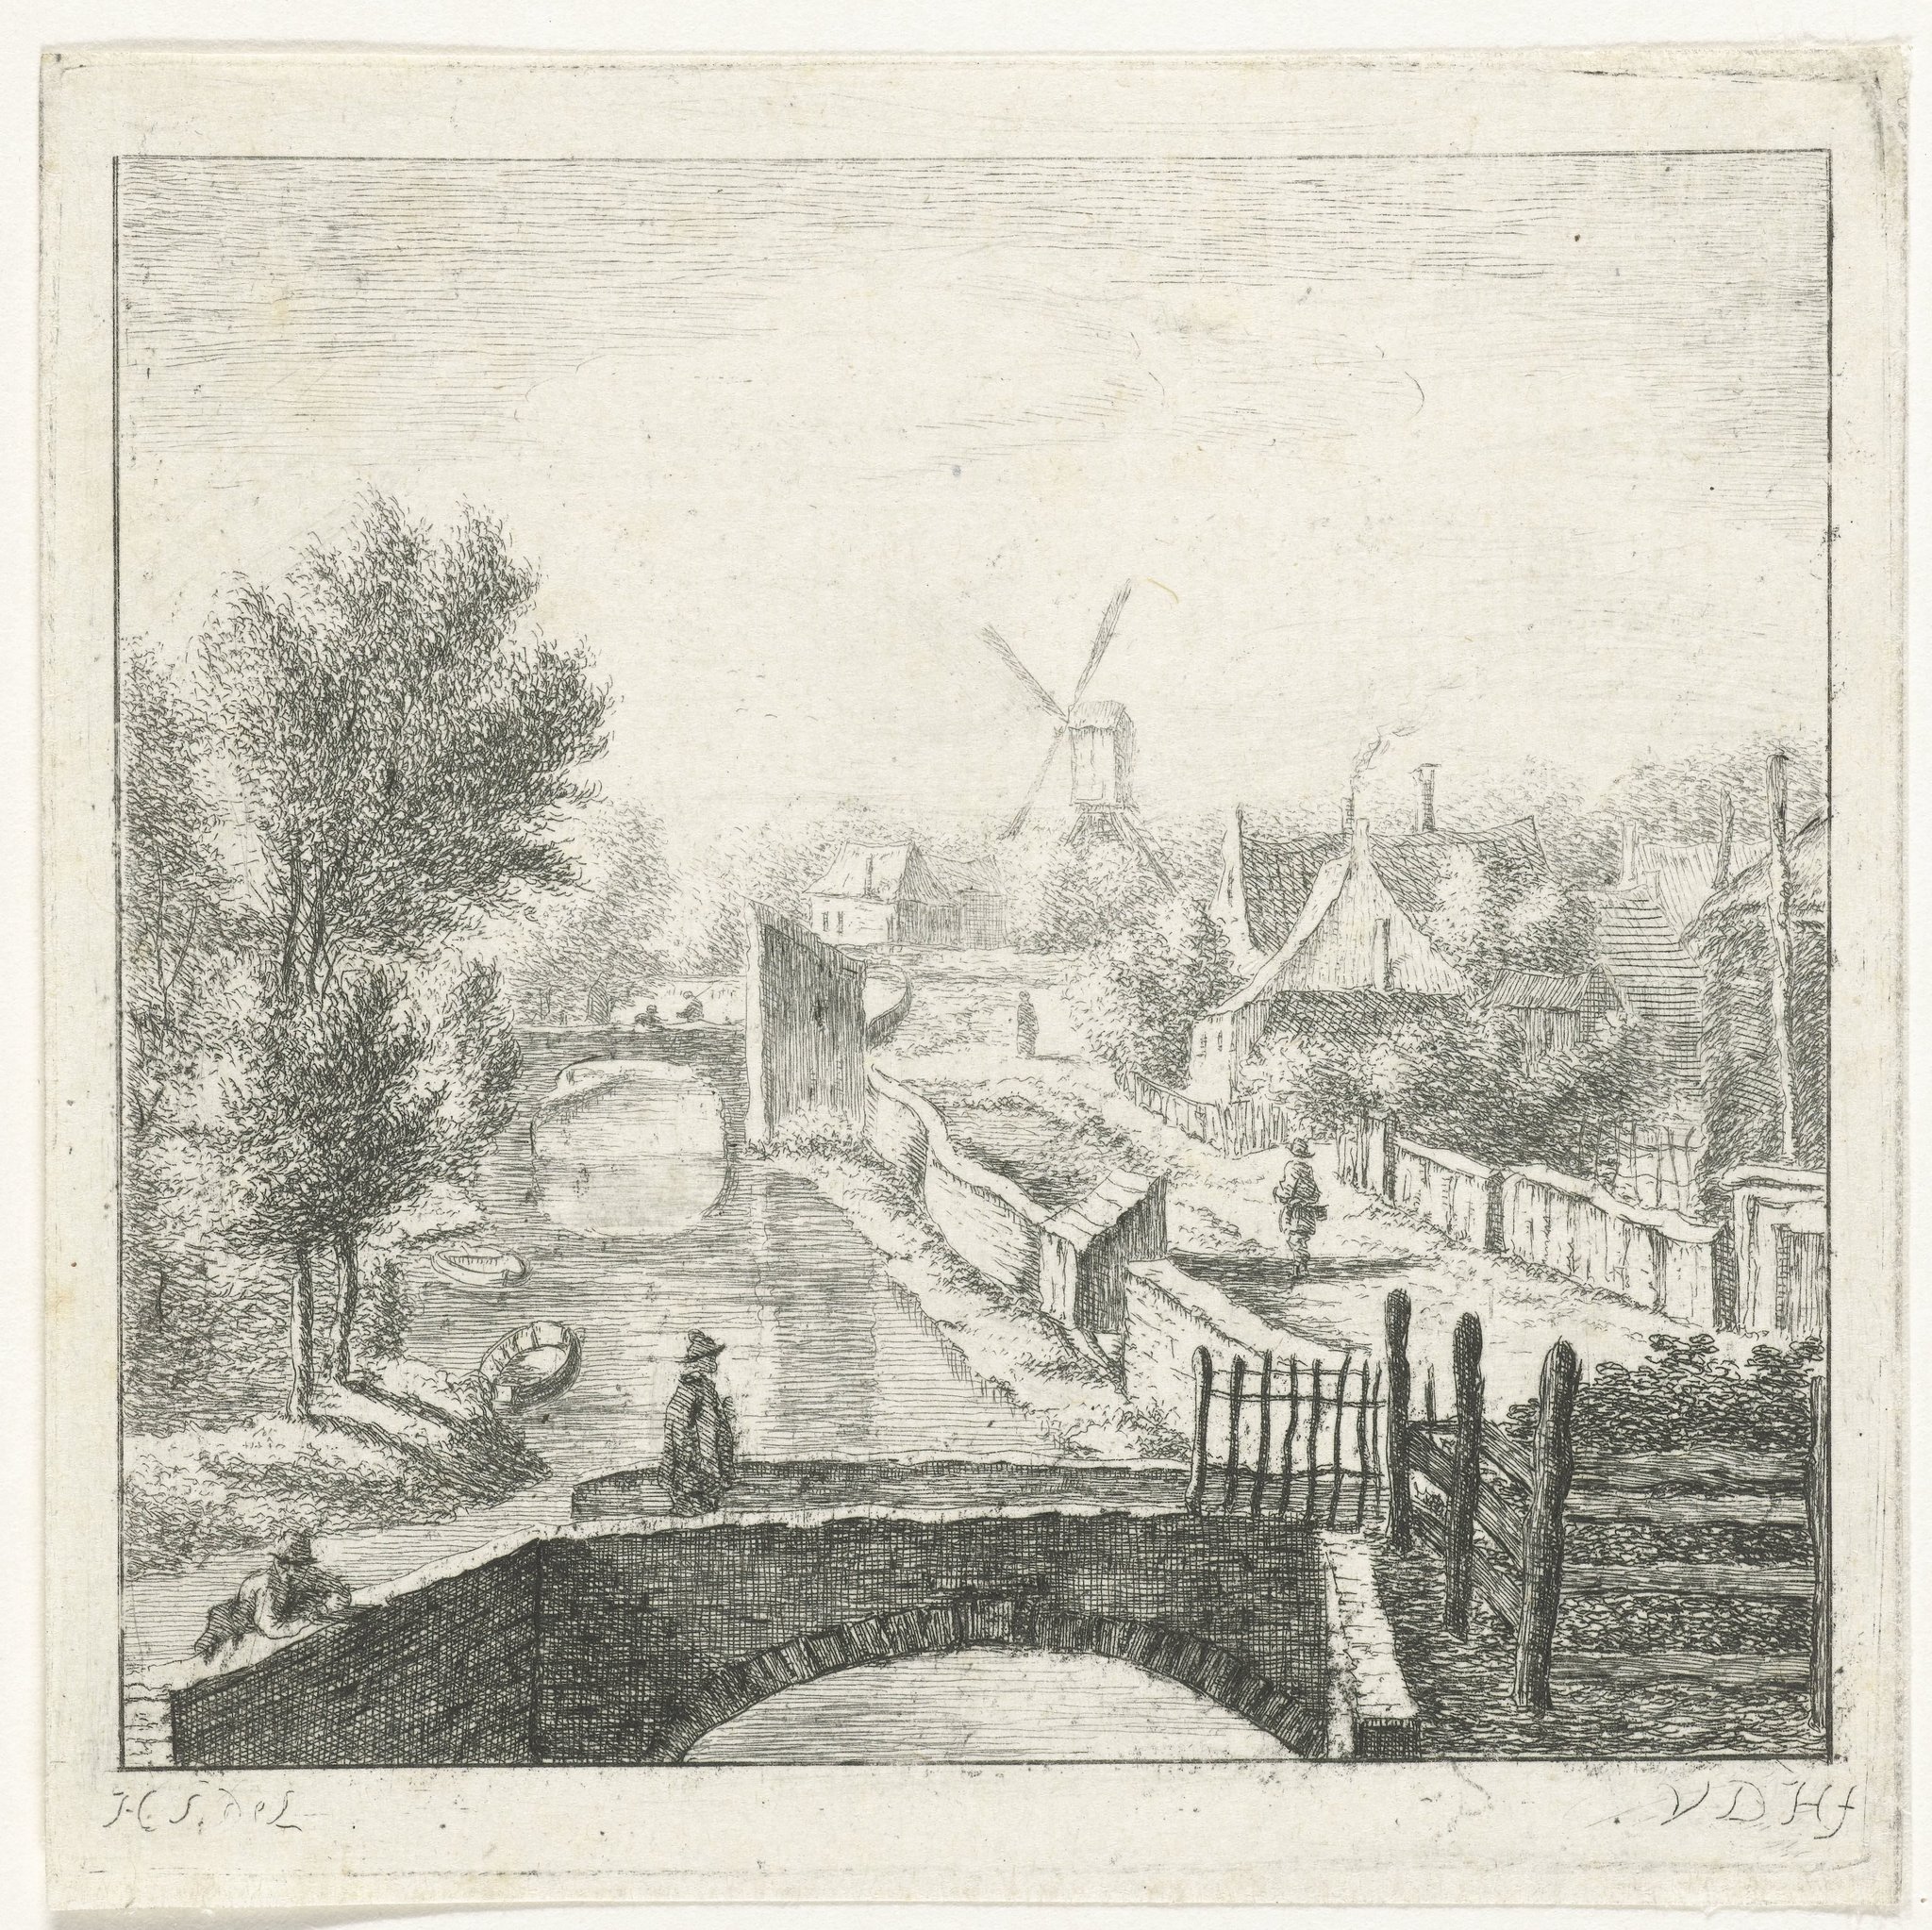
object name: print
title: Stroompje te Utrecht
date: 1745-1785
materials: paper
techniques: etching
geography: northern netherlands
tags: landscape with bridge, viaduct or aqueduct (+ city(-scape) with figures, staffage), city-gate (+ city(-scape) with figures, staffage), utrecht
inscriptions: collector's mark: Lugt 2228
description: Figuren op een brug en op een pad bij het Stroompje te Utrecht.